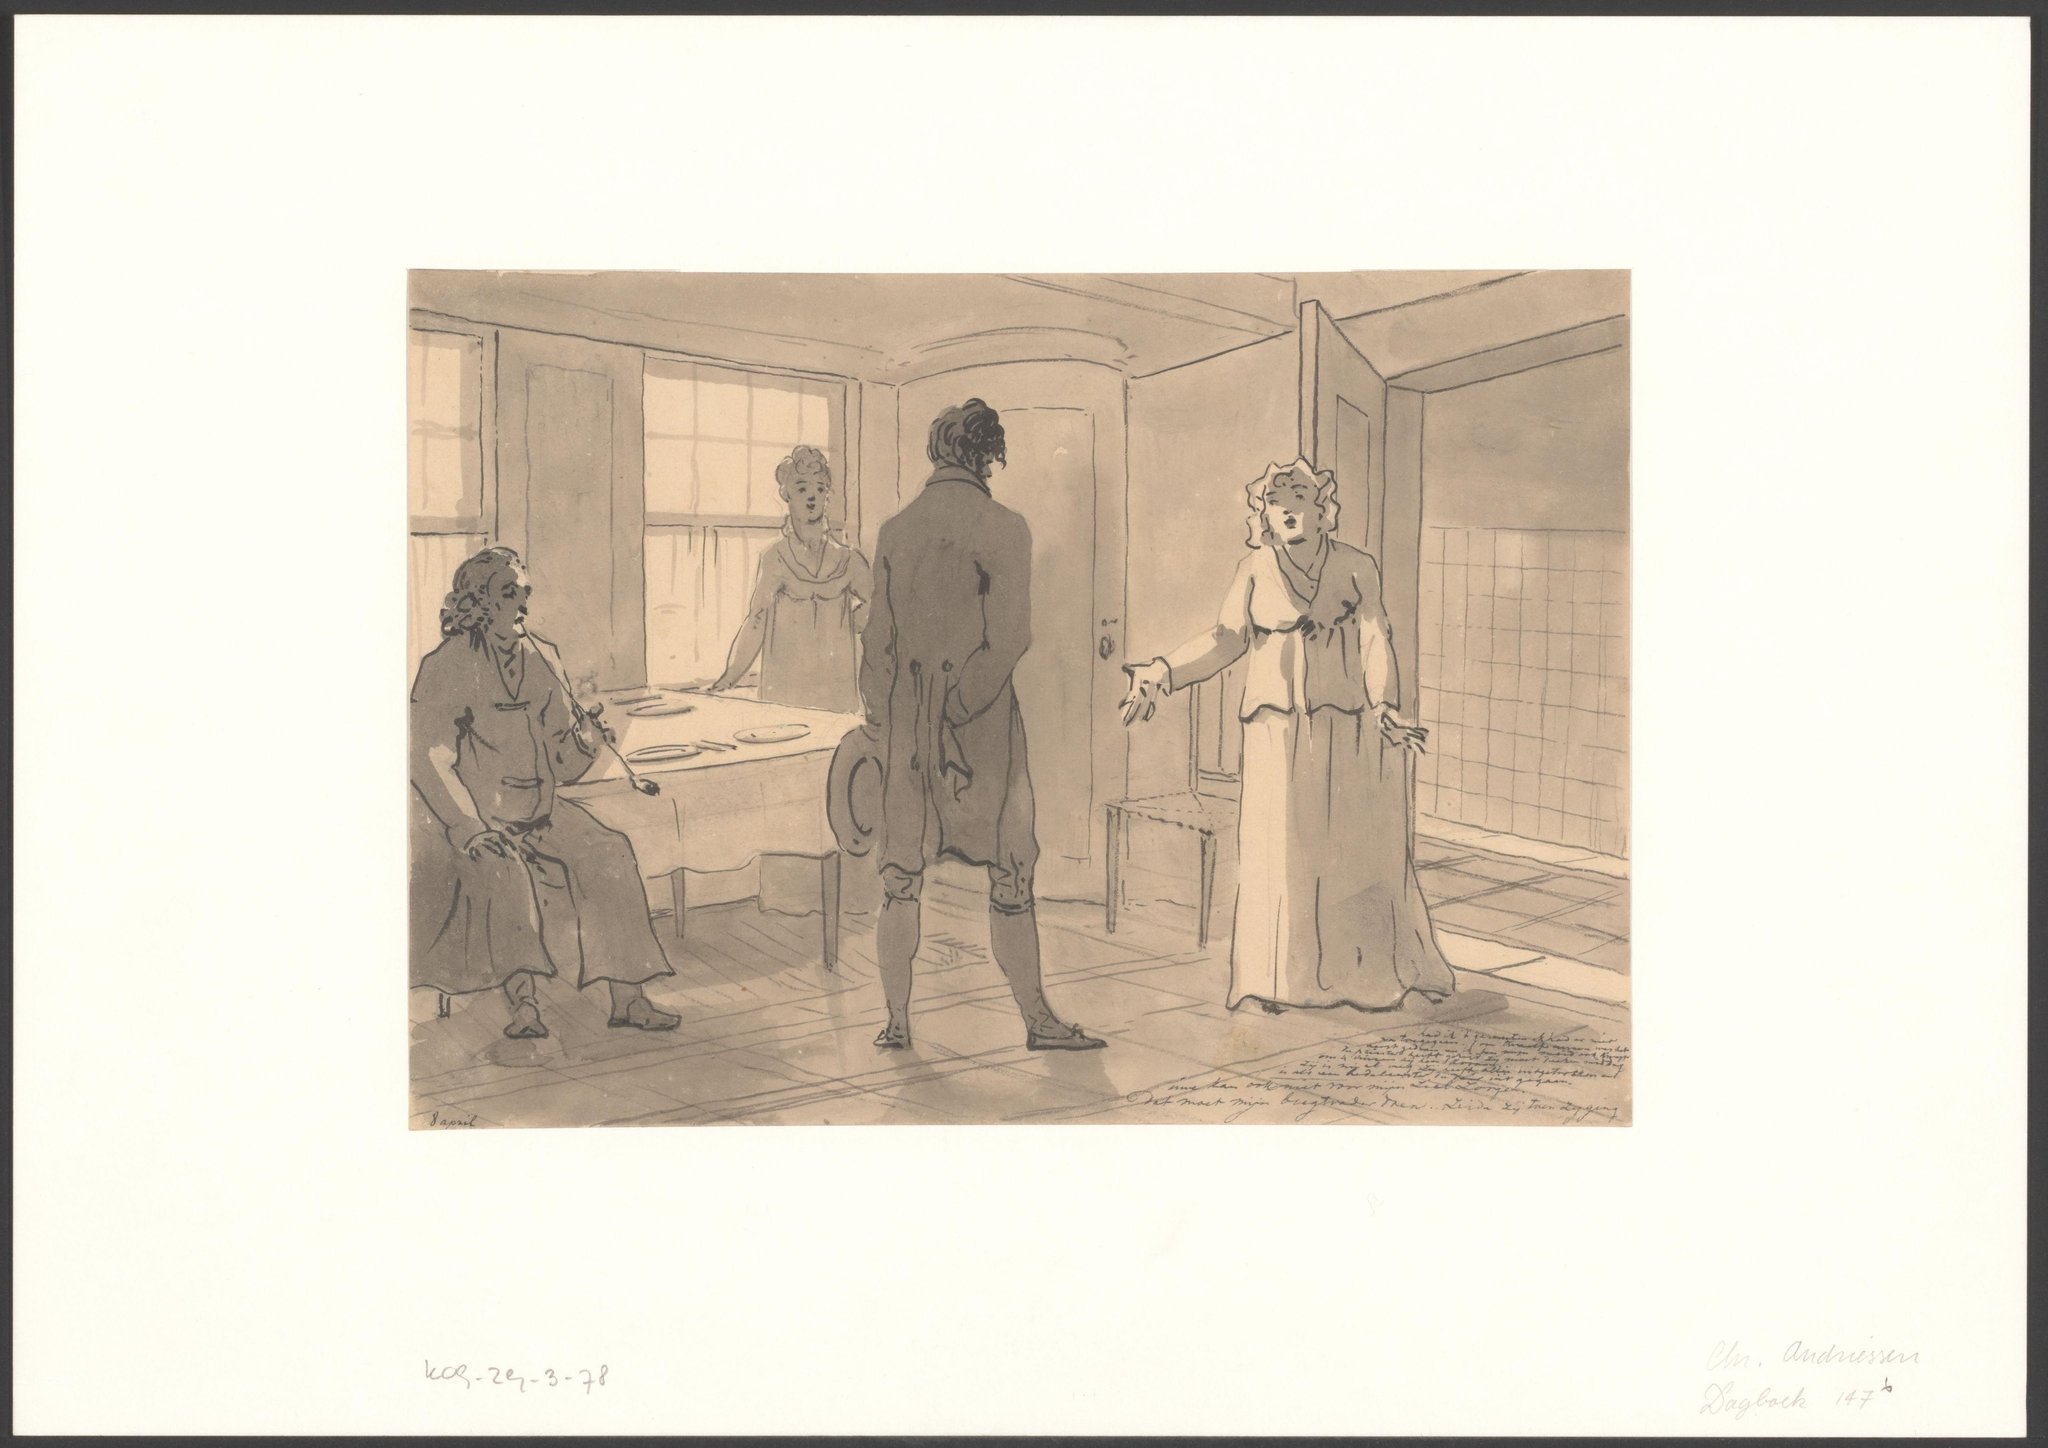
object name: drawing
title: Gesprek in de keuken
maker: christiaan andriessen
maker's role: draughtsman, print maker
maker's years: 1775-1846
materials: ink, paper, pencil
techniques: brush, pen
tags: kitchen-interior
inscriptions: inscription, inscription: ‘had ik 't ge(........) ik had er niet (...)’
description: Dagboekblad uit het getekende dagboek dat Christiaan Andriessen bijhield van 1805 tot en met 1808.